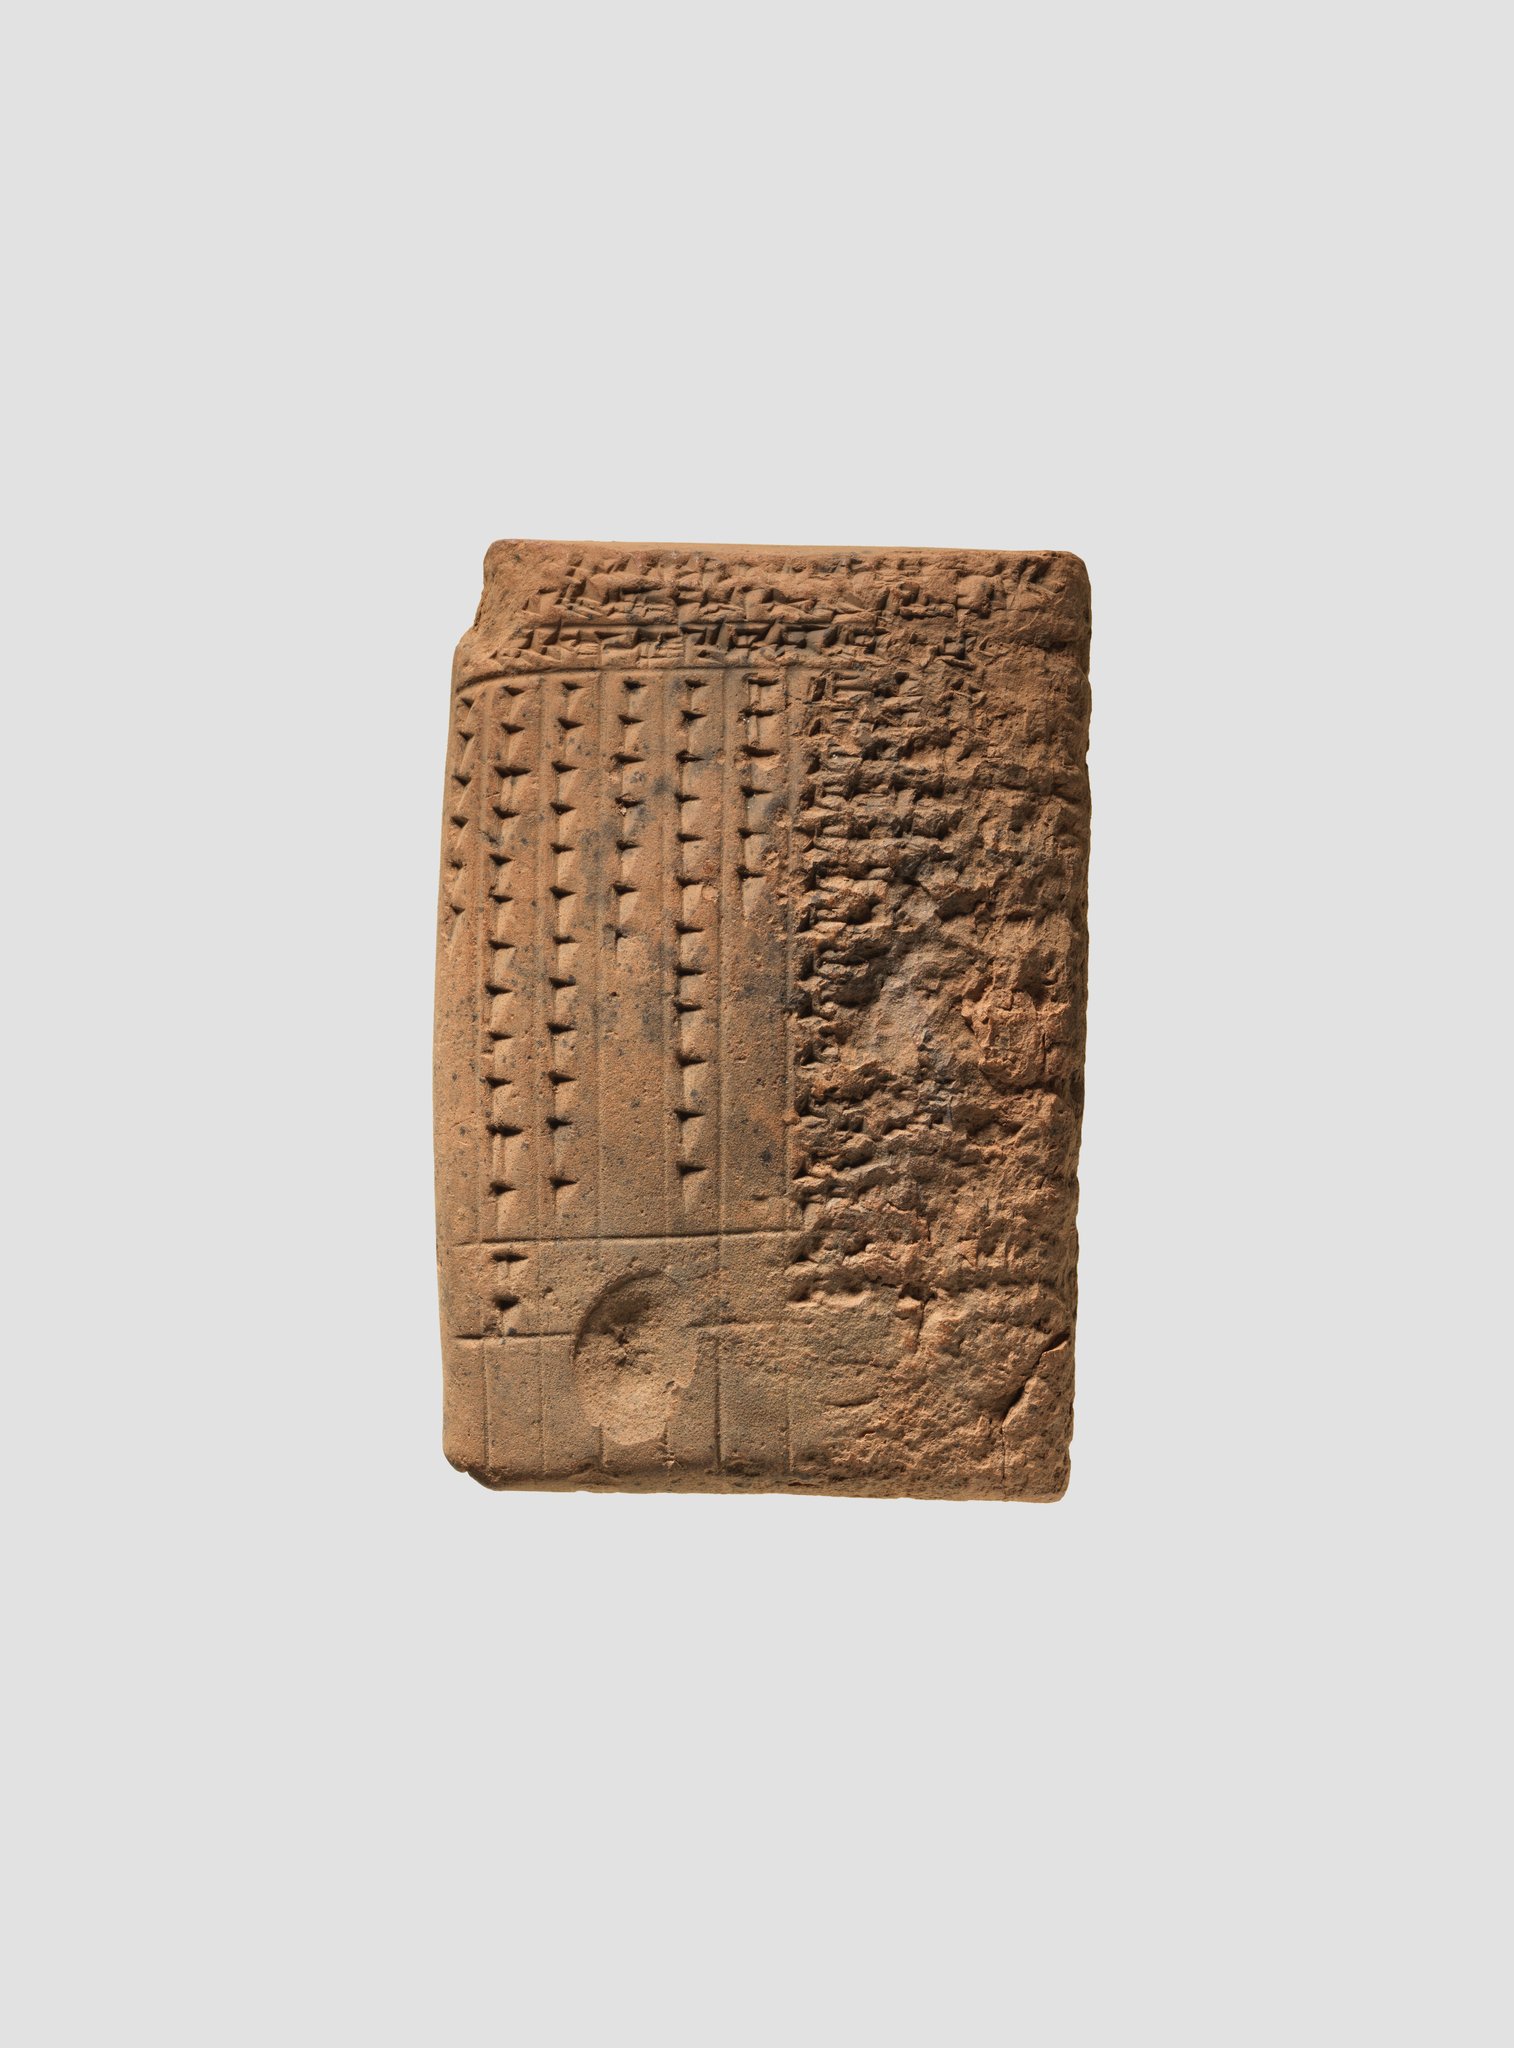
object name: cuneiform tablet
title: Cuneiform tablet: account of delivery of animals for offering, Ebabbar archive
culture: babylonian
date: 604-562 BCE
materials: clay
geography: mesopotamia